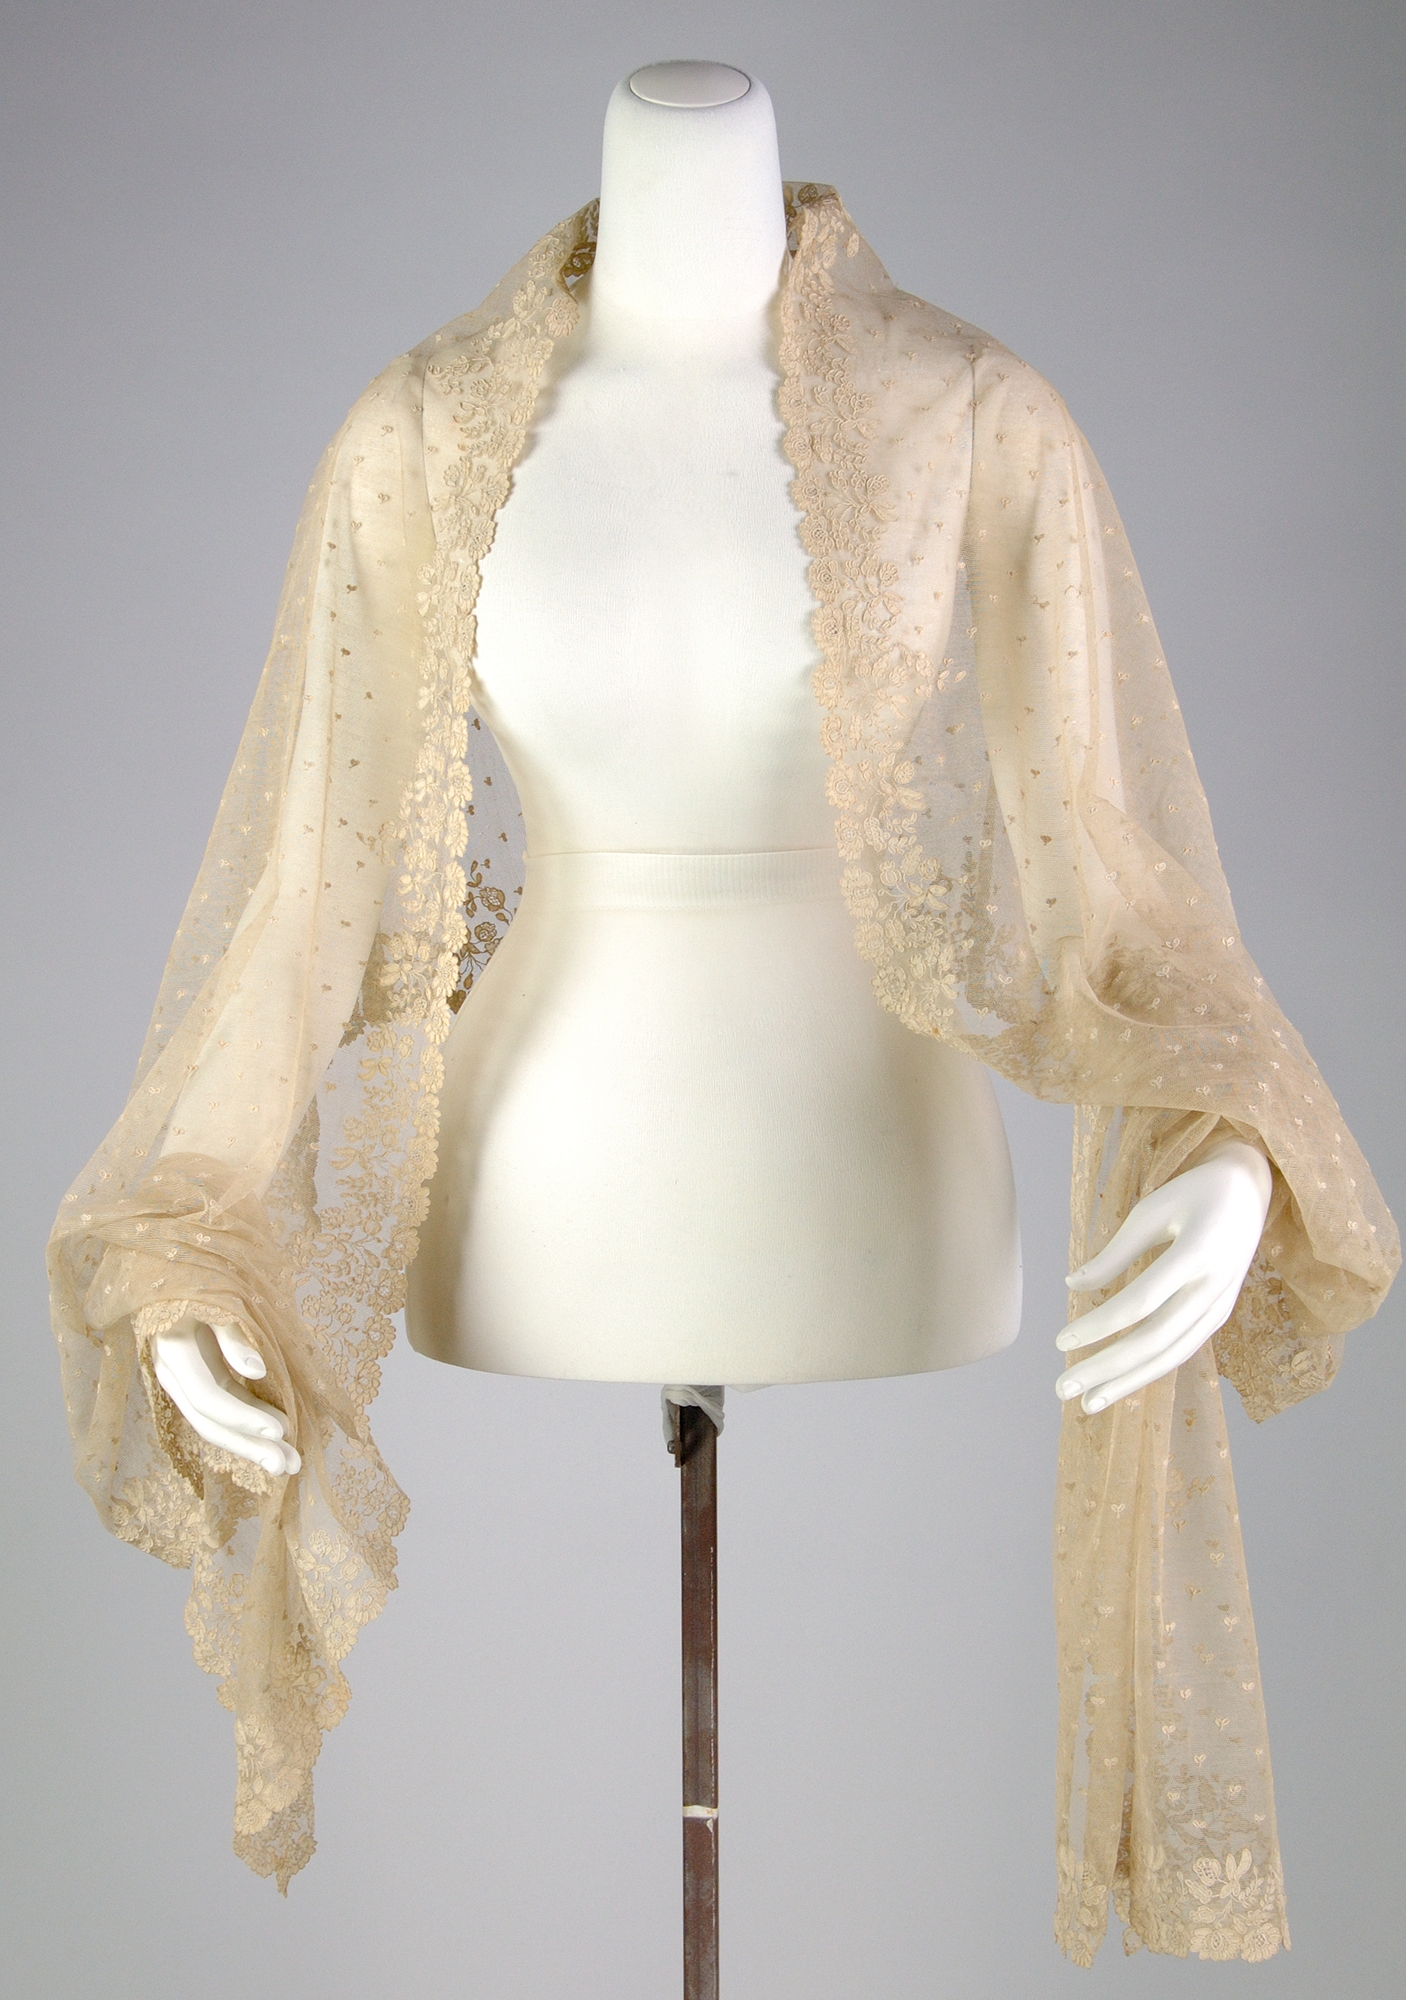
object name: stole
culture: french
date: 1801-1825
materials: linen, silk